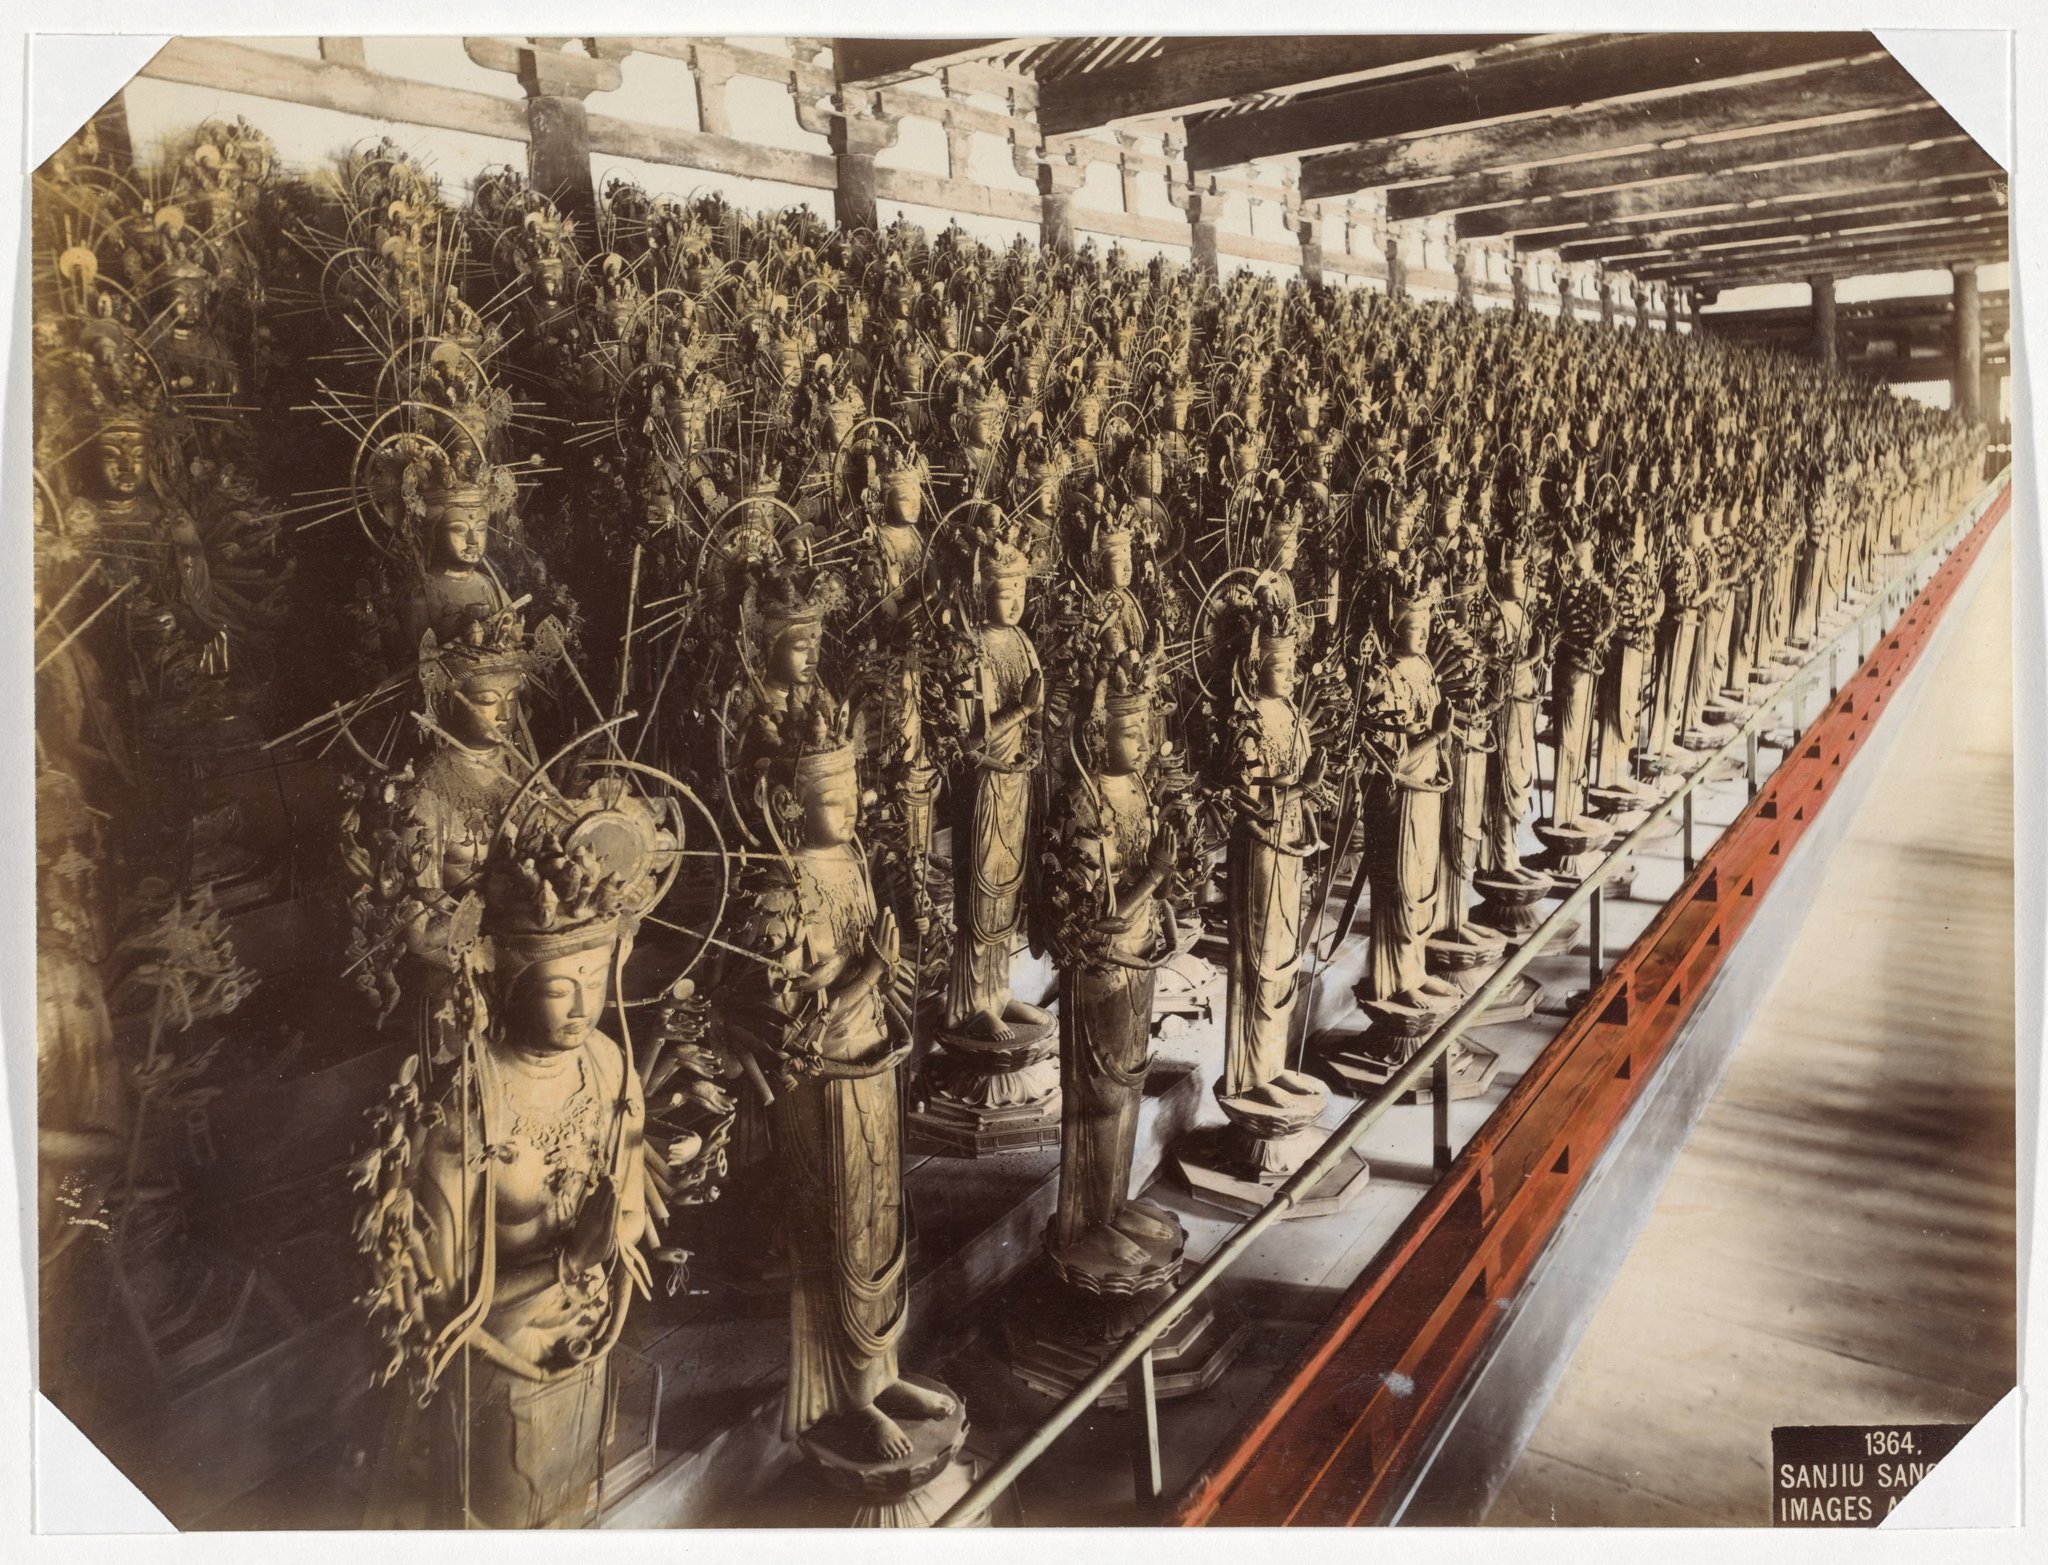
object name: photograph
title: Beelden in Sanjusangen-tempel in Kyoto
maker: Anonymous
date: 1890-1894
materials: cardboard, paper, photographic support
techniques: albumen print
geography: kyoto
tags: temple, shrine ~ hinduism, buddhism, jainism, statues, paintings, etc. ~ objects of worship (hinduism, buddhism, jainism) - hh - in the open air, kyoto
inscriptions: negative number: ‘1364’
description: Onderdeel van Album met 69 foto's van een reis door Japan.